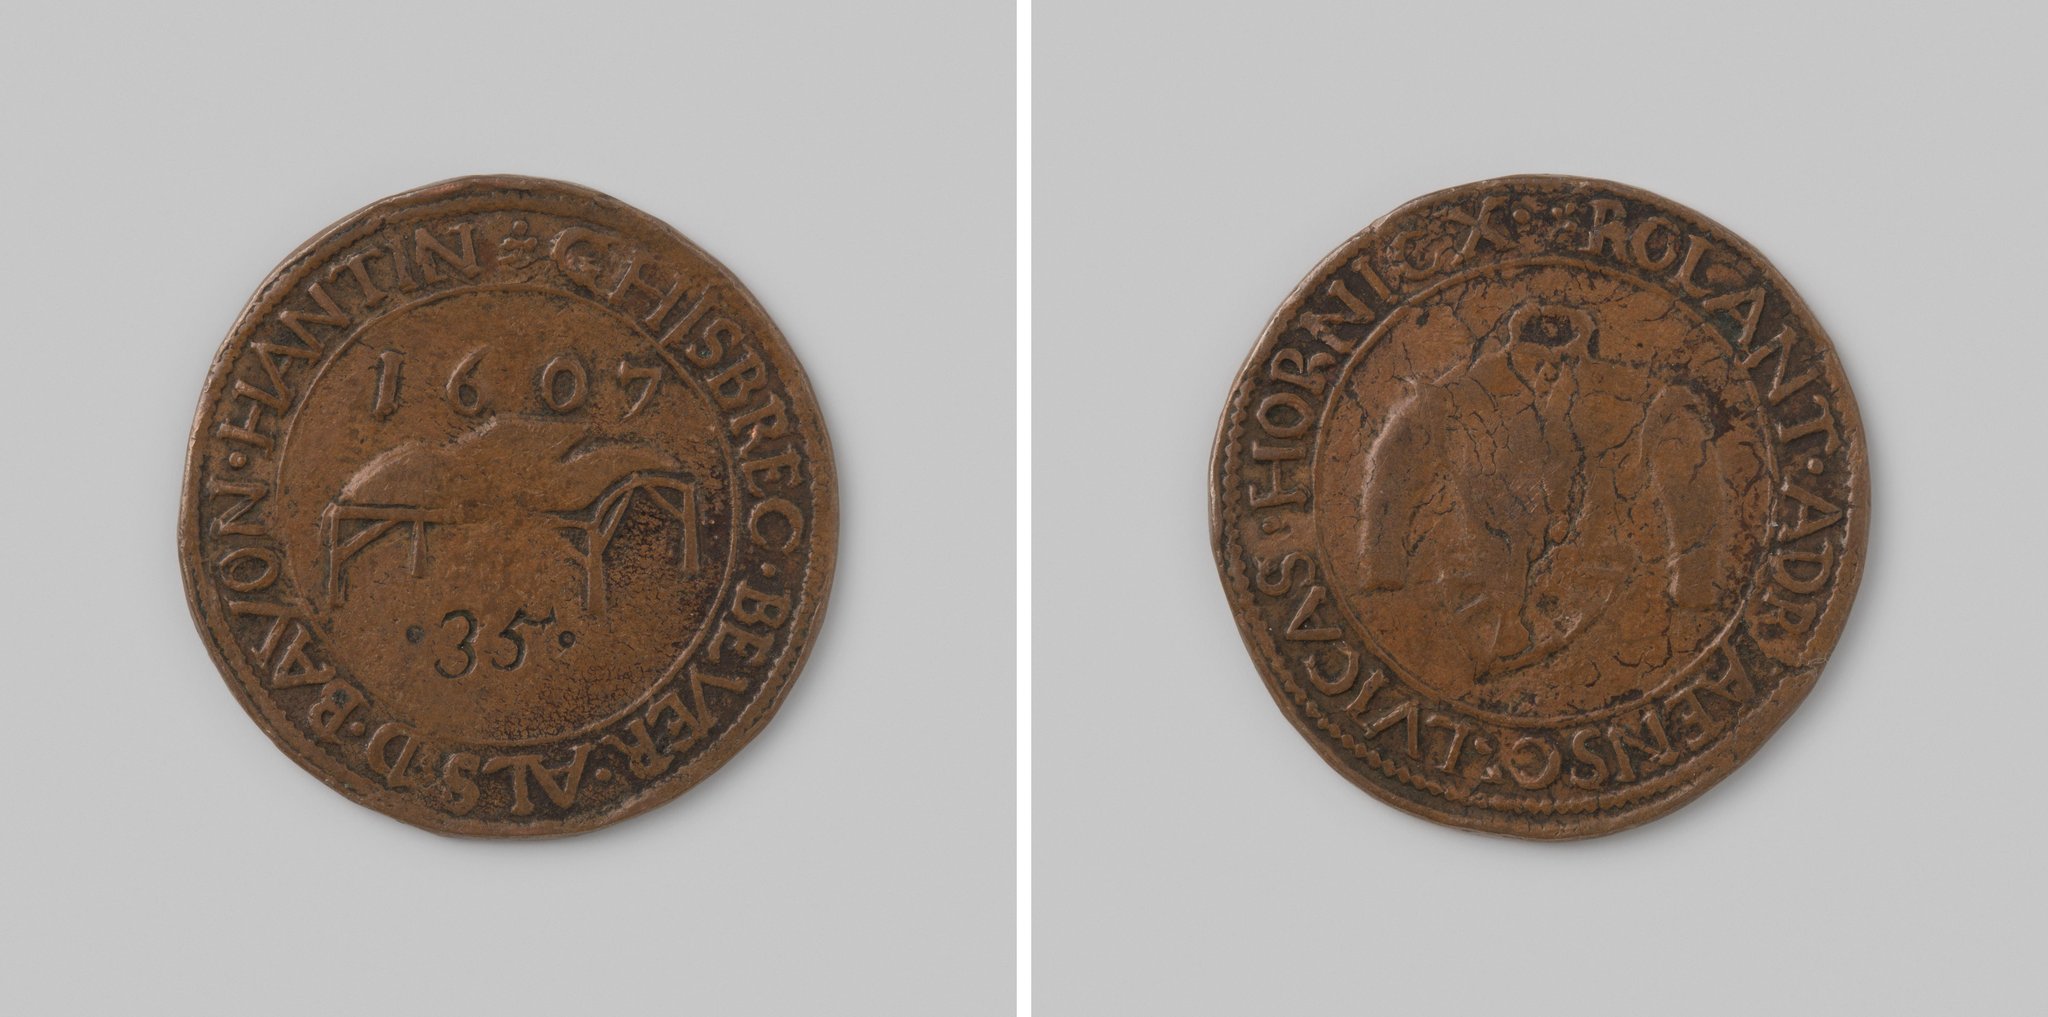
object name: medal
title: Presentiepenning van het Oudekleerkopersgilde te Middelburg 1607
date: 1607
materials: brass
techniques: striking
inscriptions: circumscription: ‘(klaverblad) ROLANT ADRIAENSC LVICAS HORNICX’, inscription: ‘.35.’, circumscription: ‘(klaverblad) GHISBREC BEVER ALS D BAVON HANTIN’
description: Geslagen koperen penning, op de voorzijde een uitdragerstafel met kleren onder 1607, met instempeling 35 en omschrift, op de keerzijde een wambuis met omschrift